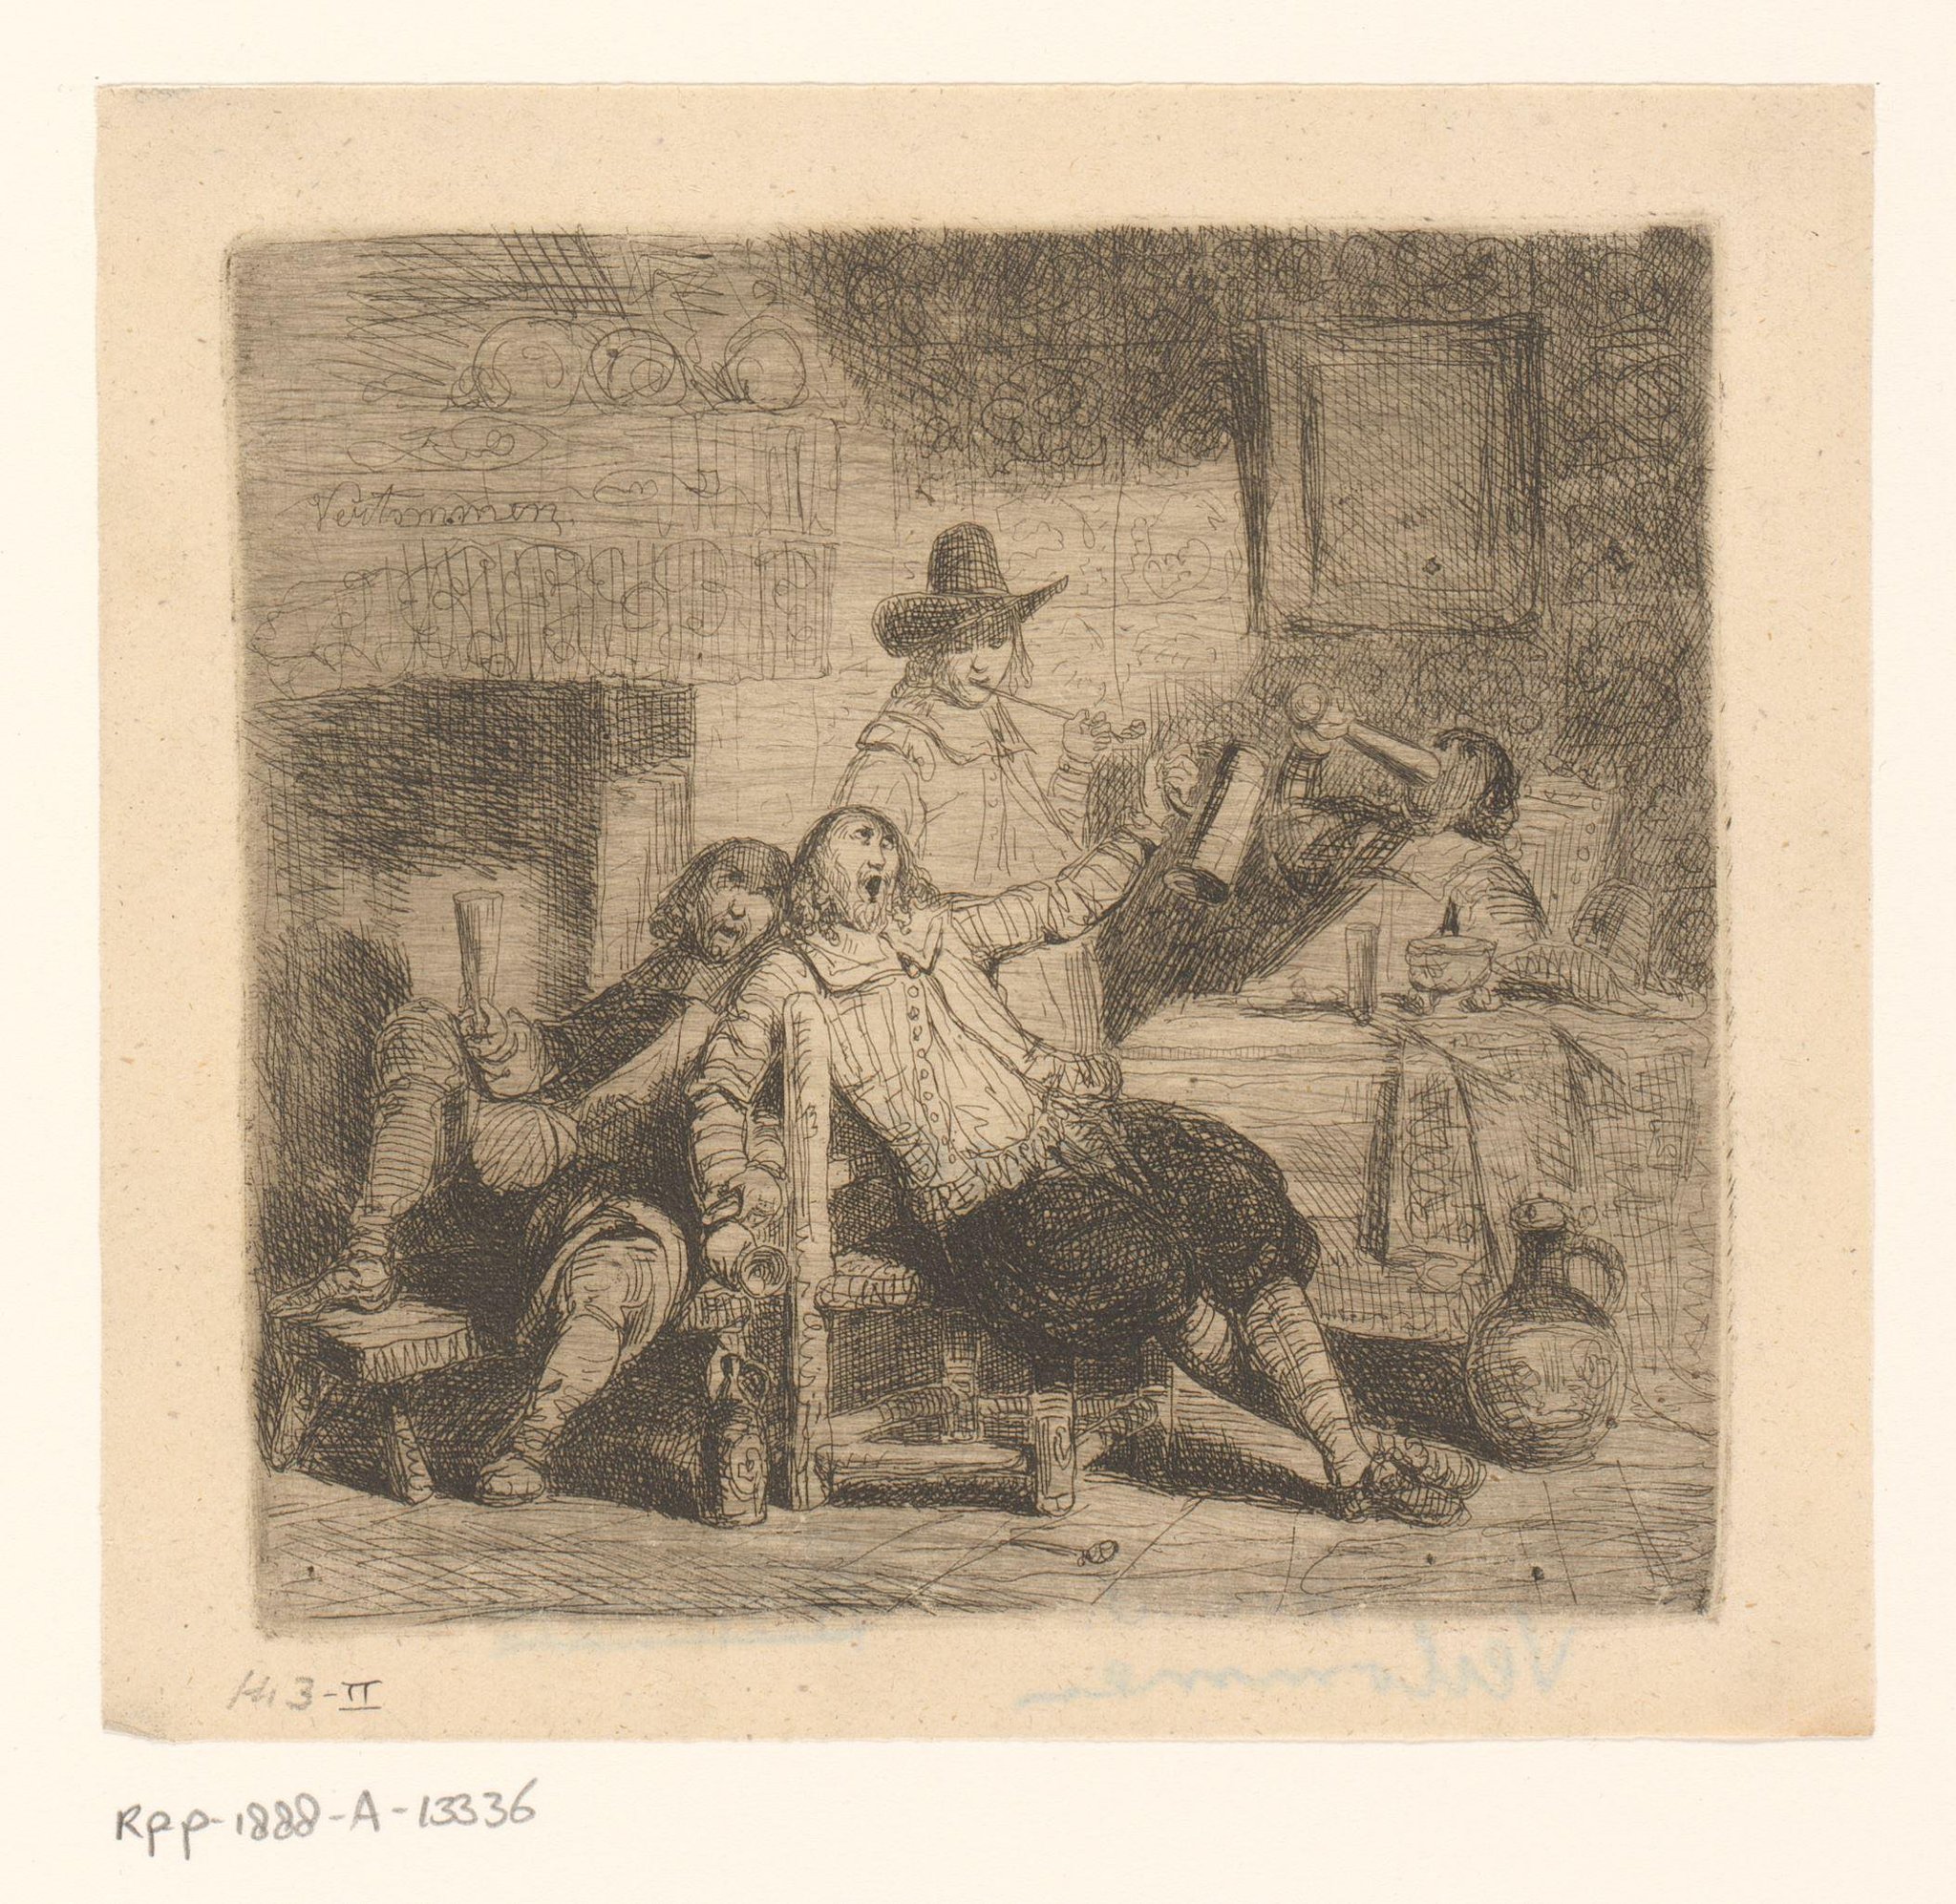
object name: print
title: Interieur met vier drinkende mannen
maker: guillaume joseph vertommen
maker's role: print maker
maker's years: 1815-1863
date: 1825-1863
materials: paper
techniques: etching, intaglio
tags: adult man (+ four persons), interior of the house, drinking, chimney-piece, mantelpiece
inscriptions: collector's mark: Lugt 2228